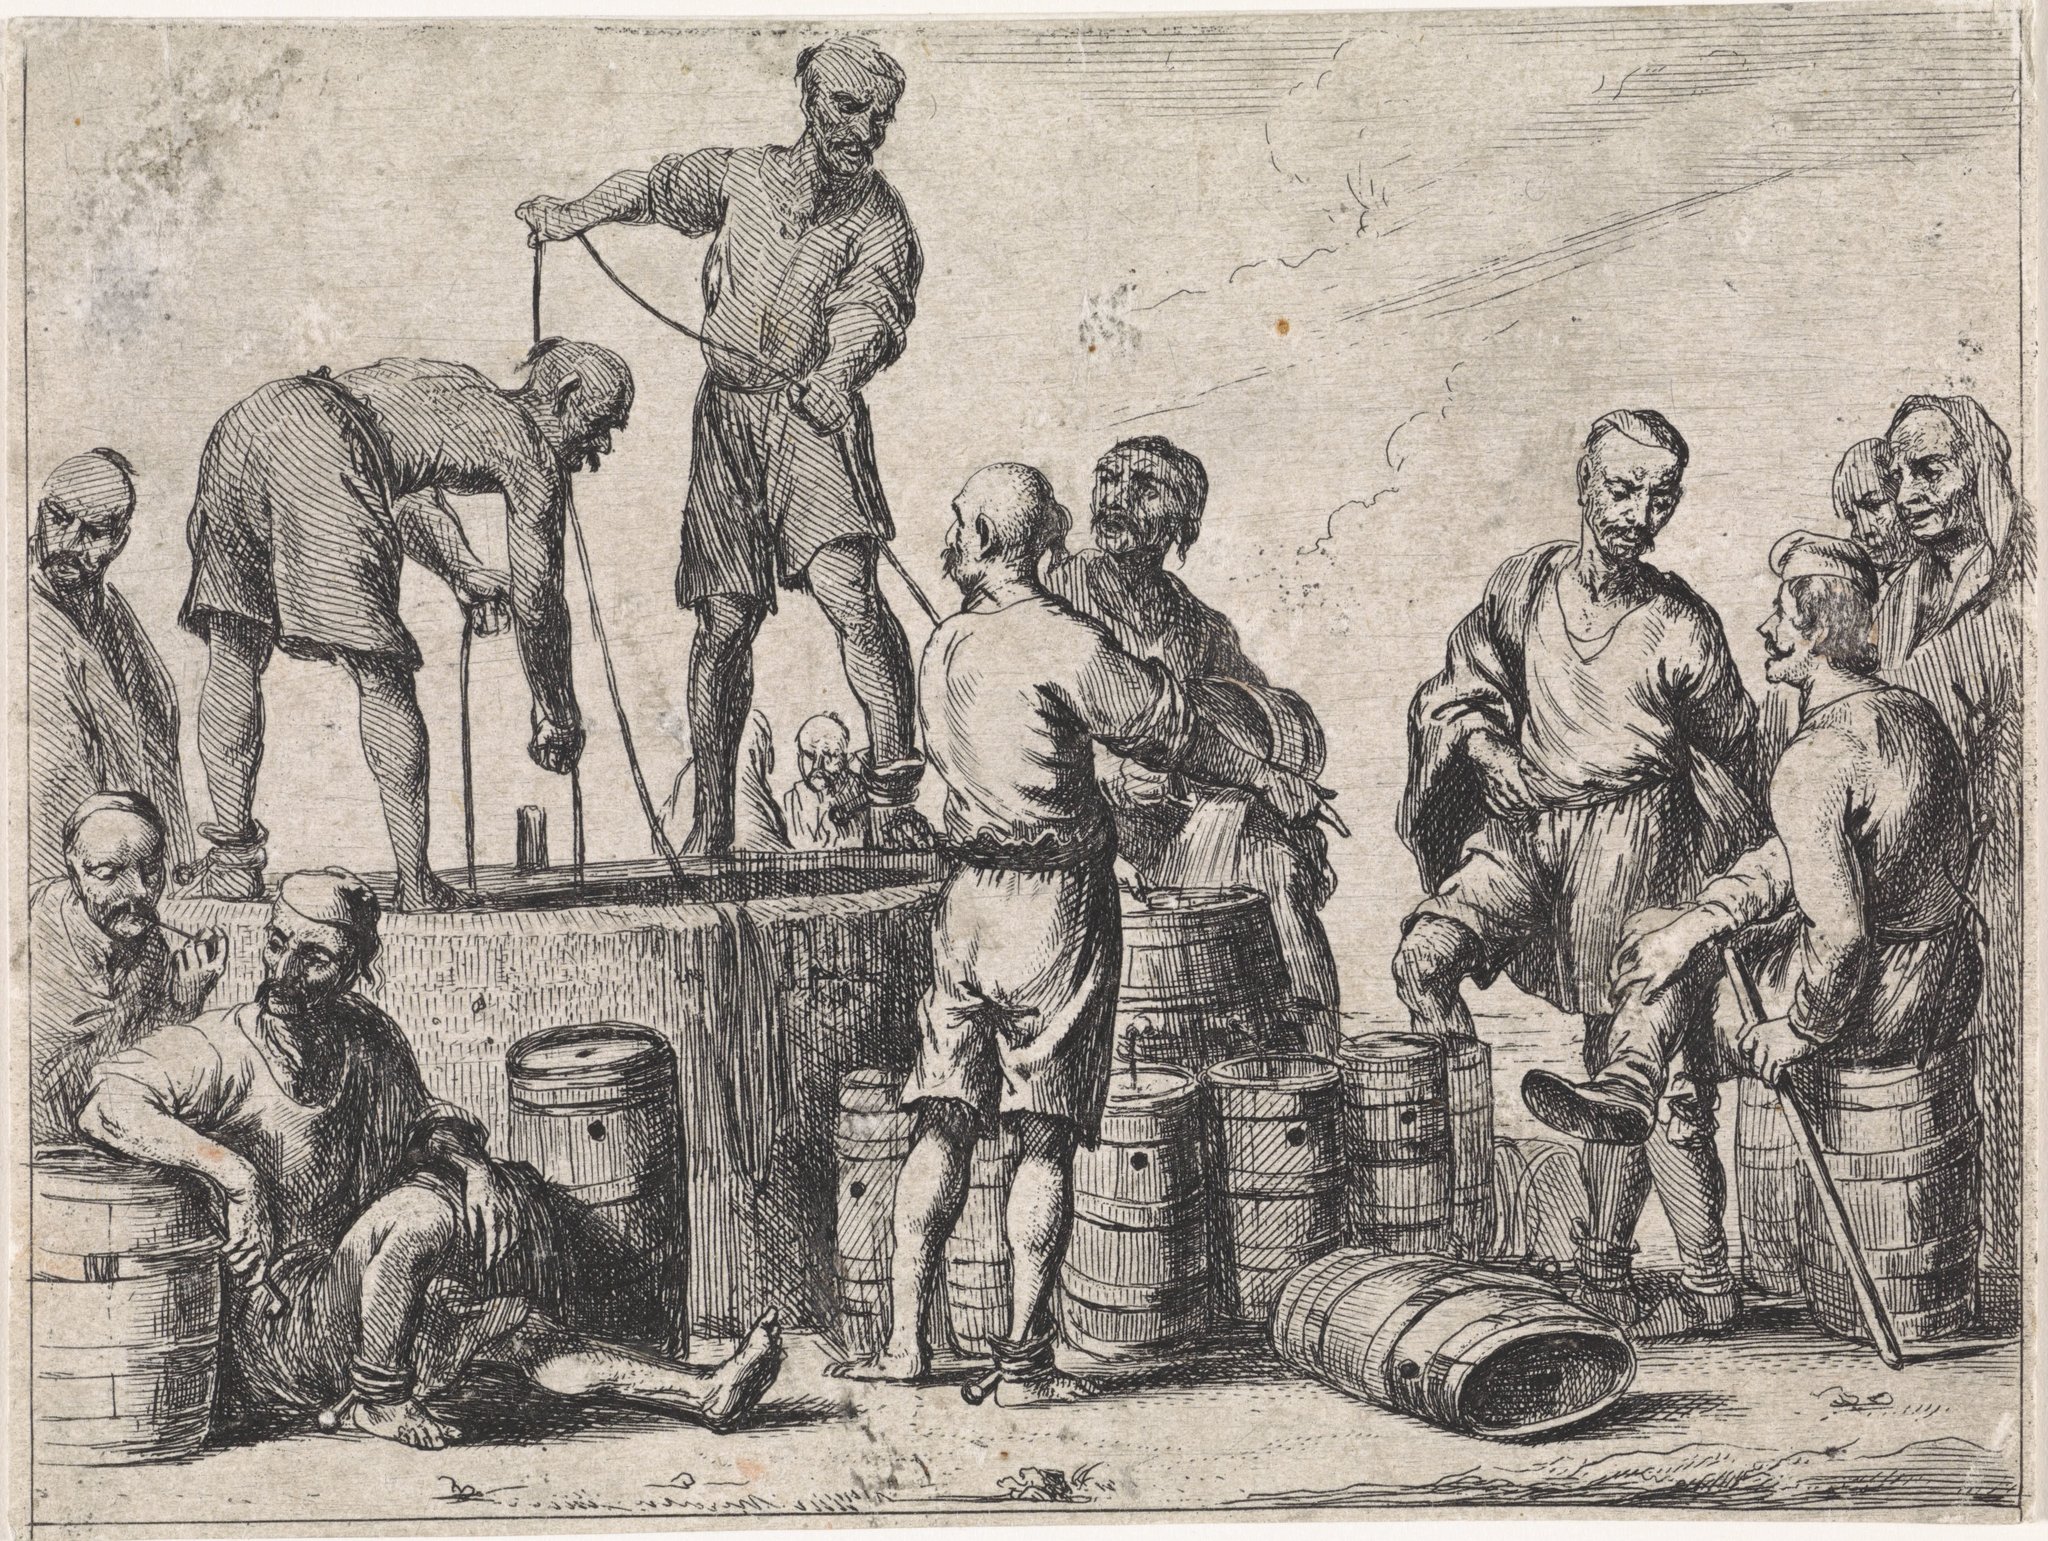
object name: print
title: Islamitische galeislaven rond een put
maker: cornelis de wael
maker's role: draughtsman, print maker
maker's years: 1592-1667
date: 1645-1647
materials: paper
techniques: engraving, etching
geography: genoa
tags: harbour, well, wooden container: barrel, cask, bucket, slavery; serfs and enslaved persons, seaman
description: Islamitische galeislaven rond een put. Ze hijsen water uit de put en gieten het in tonnen. Deze tot slaaf gemaakte mannen zijn als moslims te herkennen door het typerende kapsel (hoofd op een pluk na kaalgeschoren) dat zij verplicht waren te hebben. Rechts zit een opzichter.